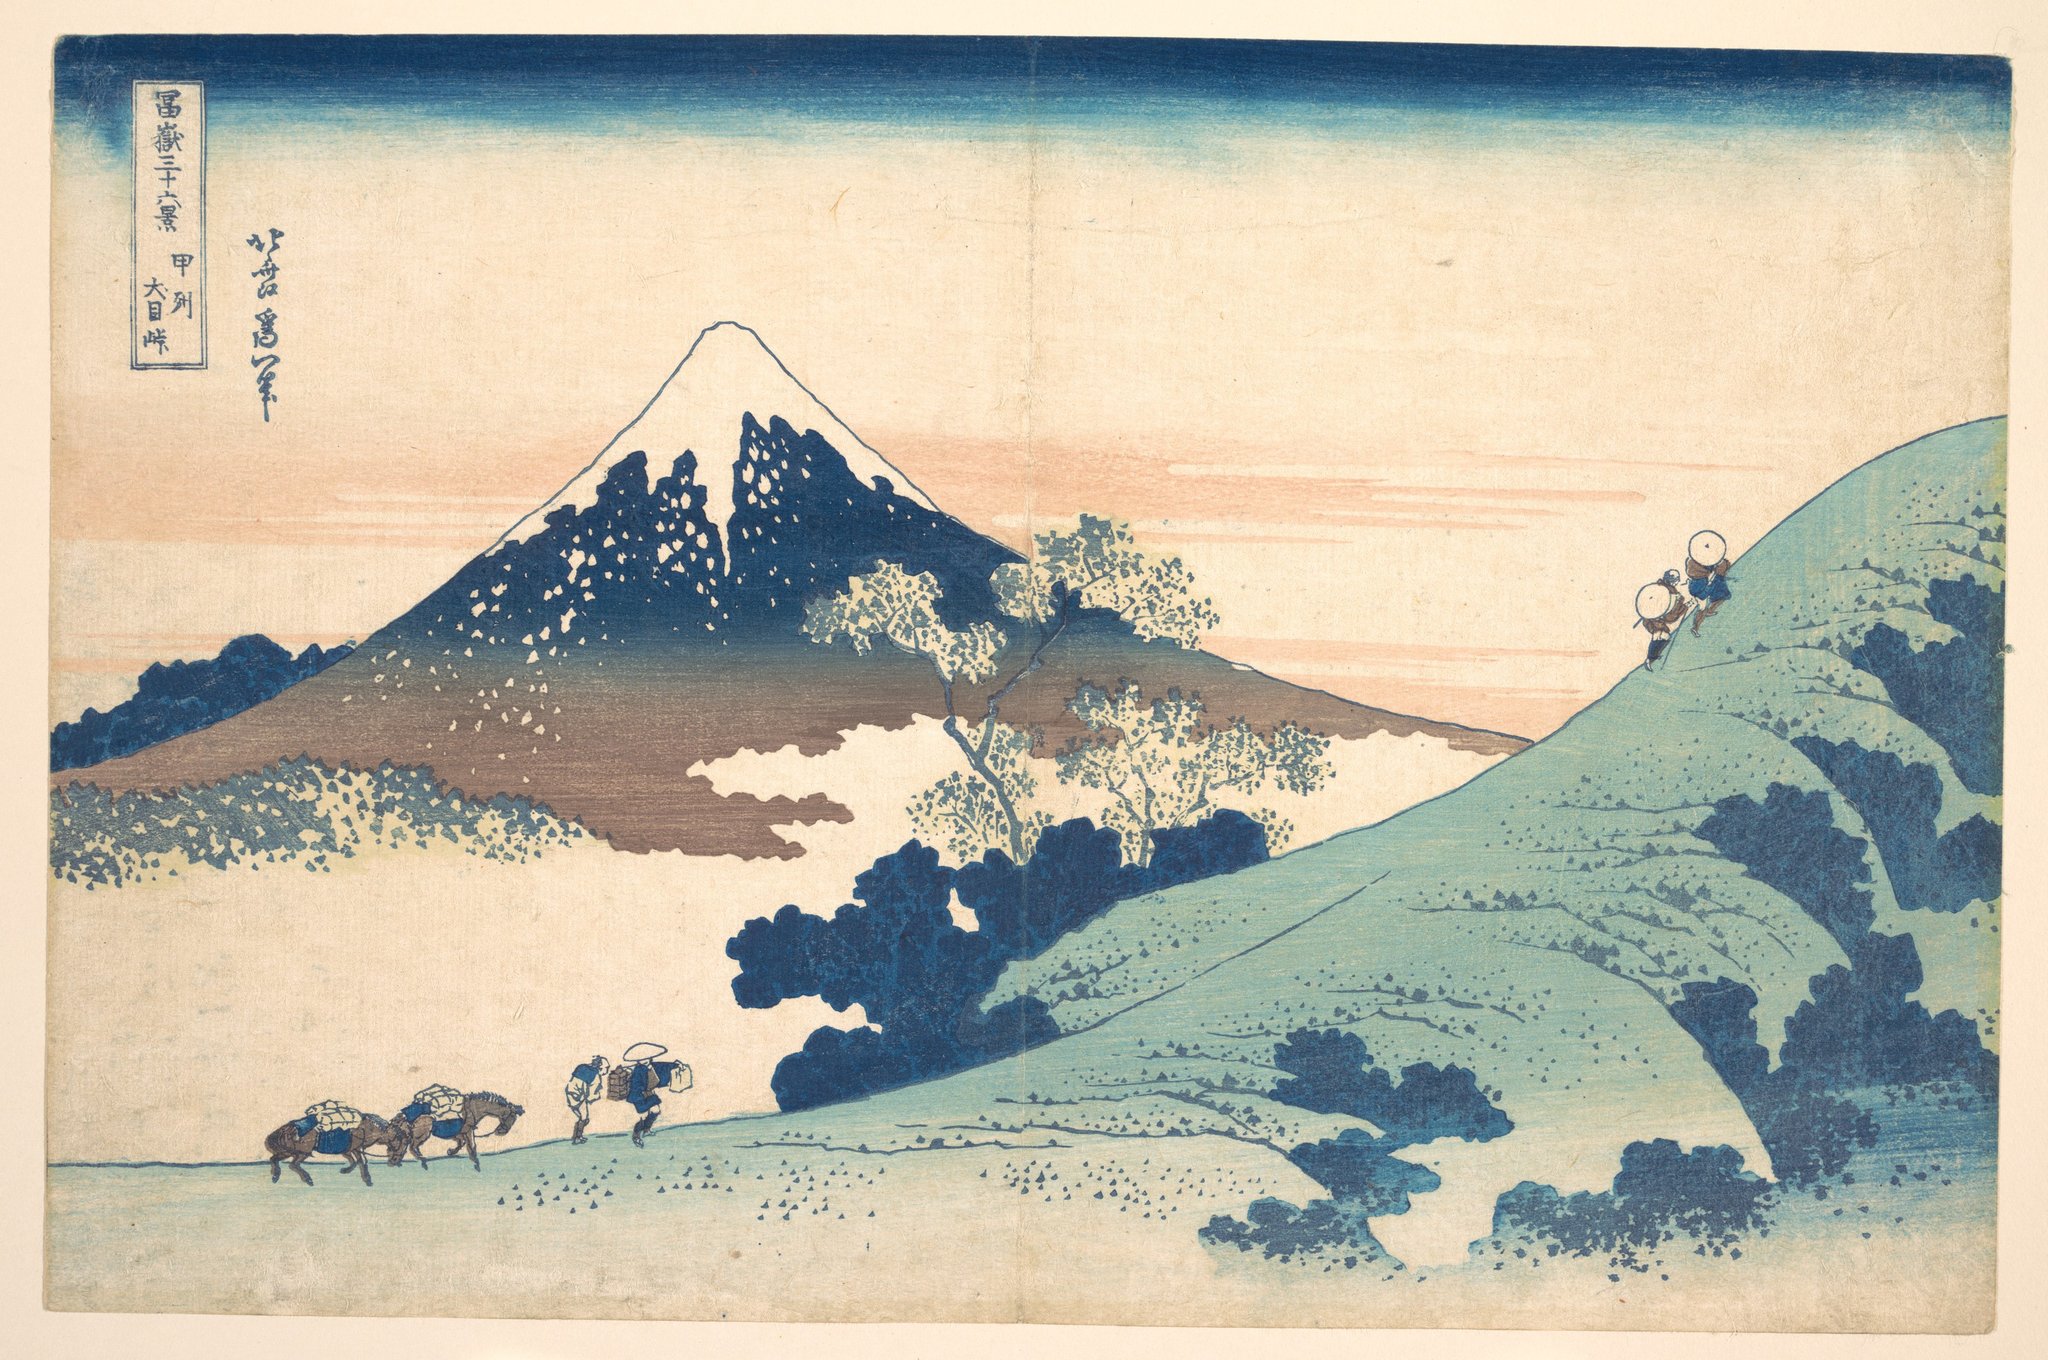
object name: print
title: Fuji from Inume (?) Pass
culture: japanese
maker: katsushika hokusai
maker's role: artist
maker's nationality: japanese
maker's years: 1760-1849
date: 1760-1849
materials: ink, paper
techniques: woodblock print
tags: human figures,horses,volcanoes,trees,snow